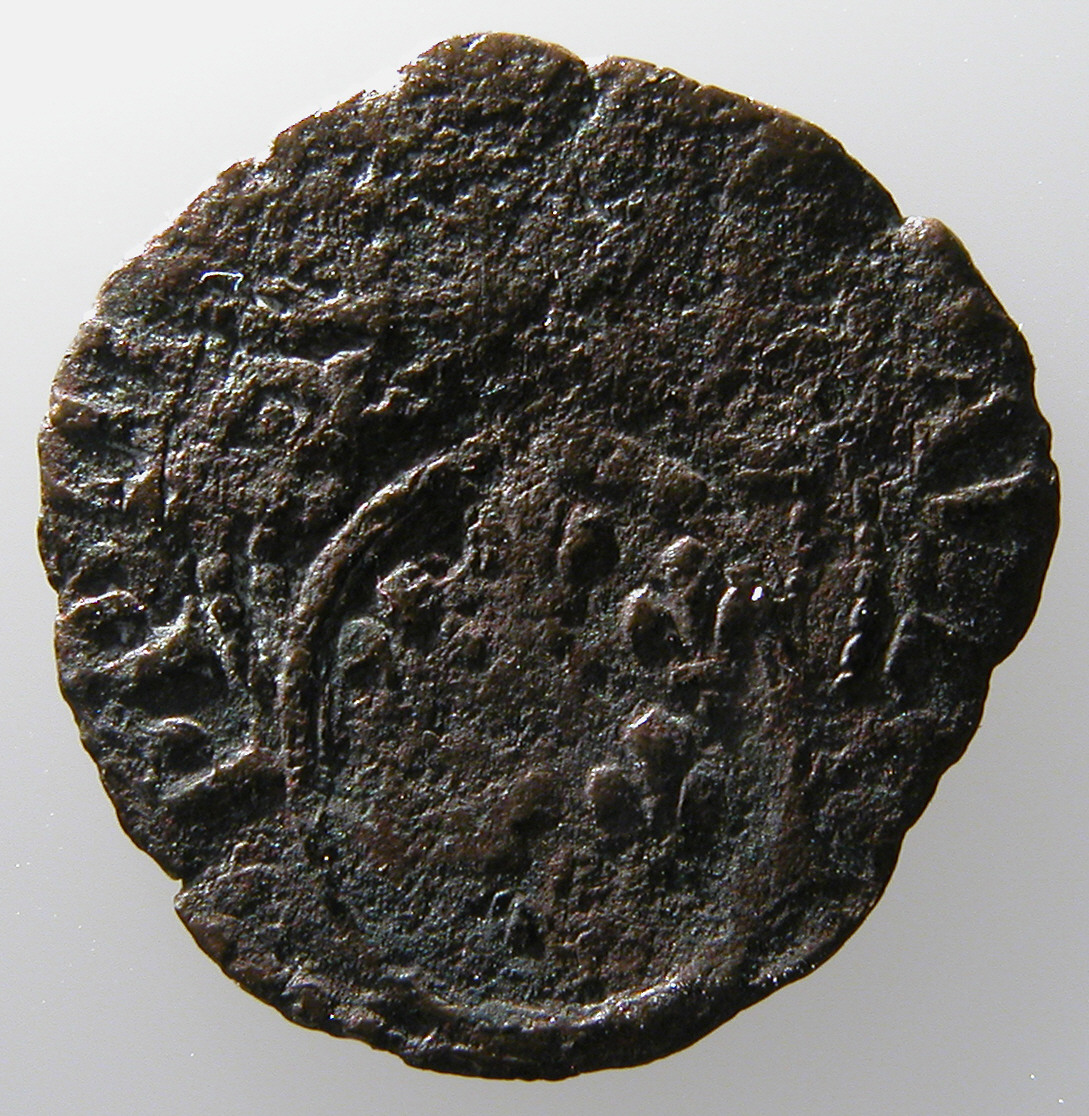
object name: coin, billon quattrino of paul iii alessandro farnese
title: Billon Quattrino of Paul III (?)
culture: italian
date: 1534-1549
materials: copper alloy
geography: italy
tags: coins